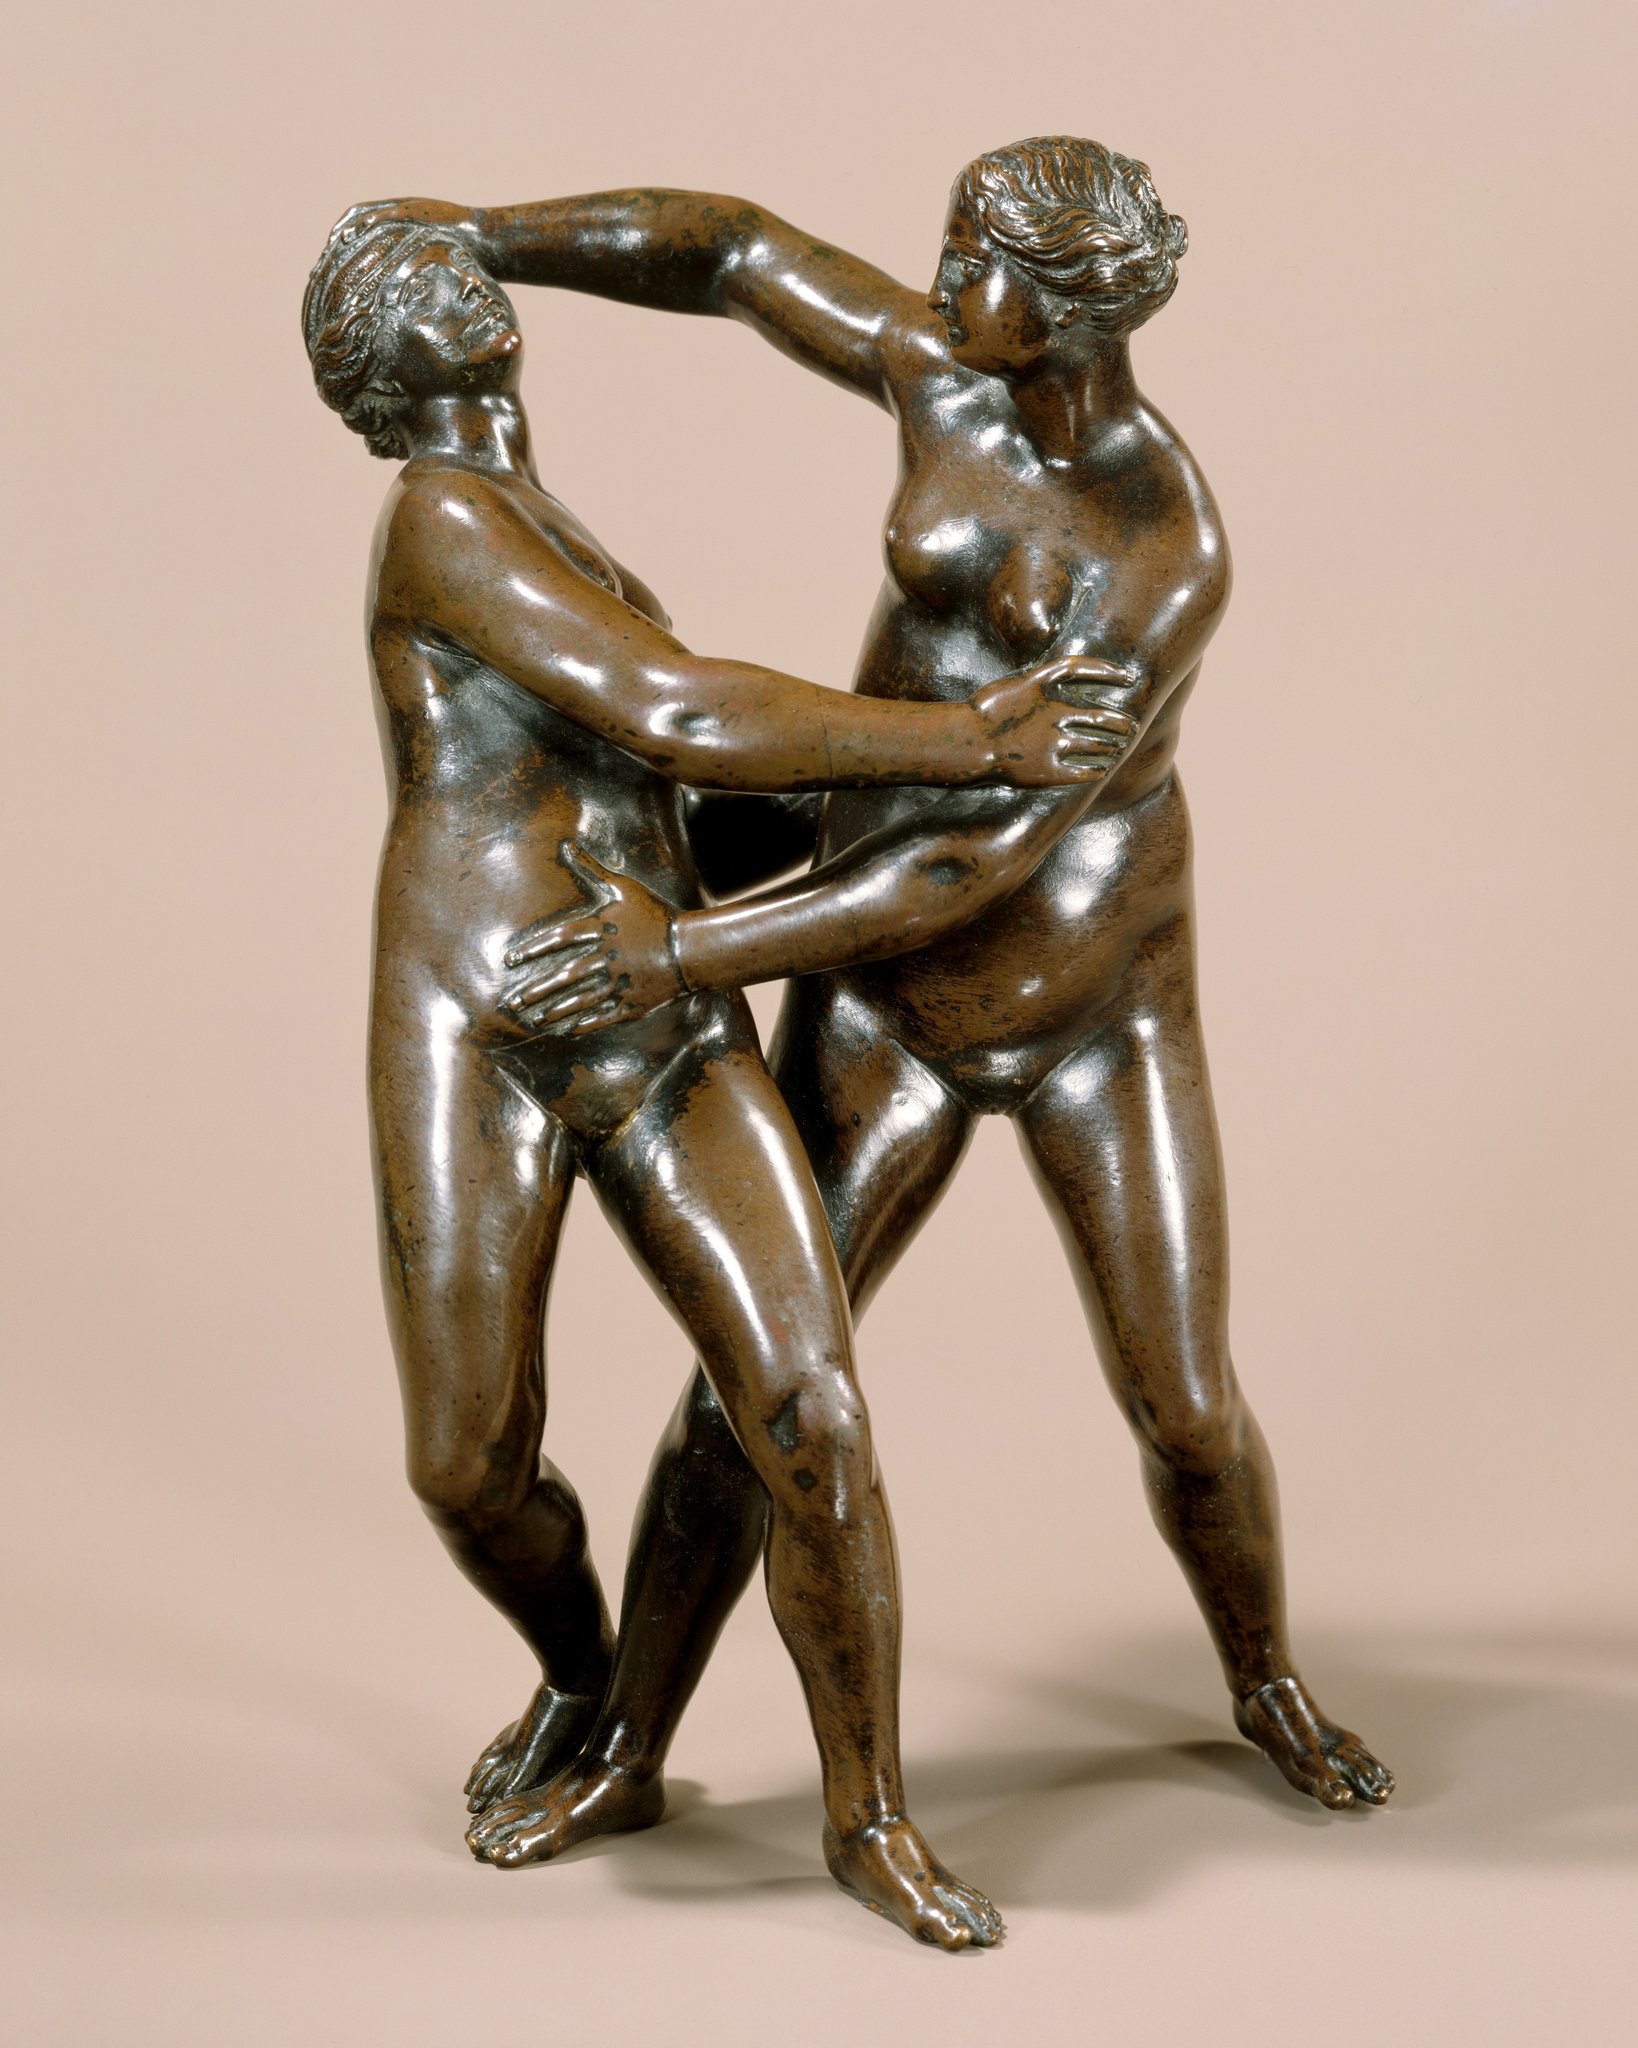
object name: statuette group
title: Nude Women Wrestling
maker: leonhard kern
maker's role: artist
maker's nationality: german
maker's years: 1588-1662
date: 1634-1666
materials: bronze, lacquer, patina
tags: female nudes,sports